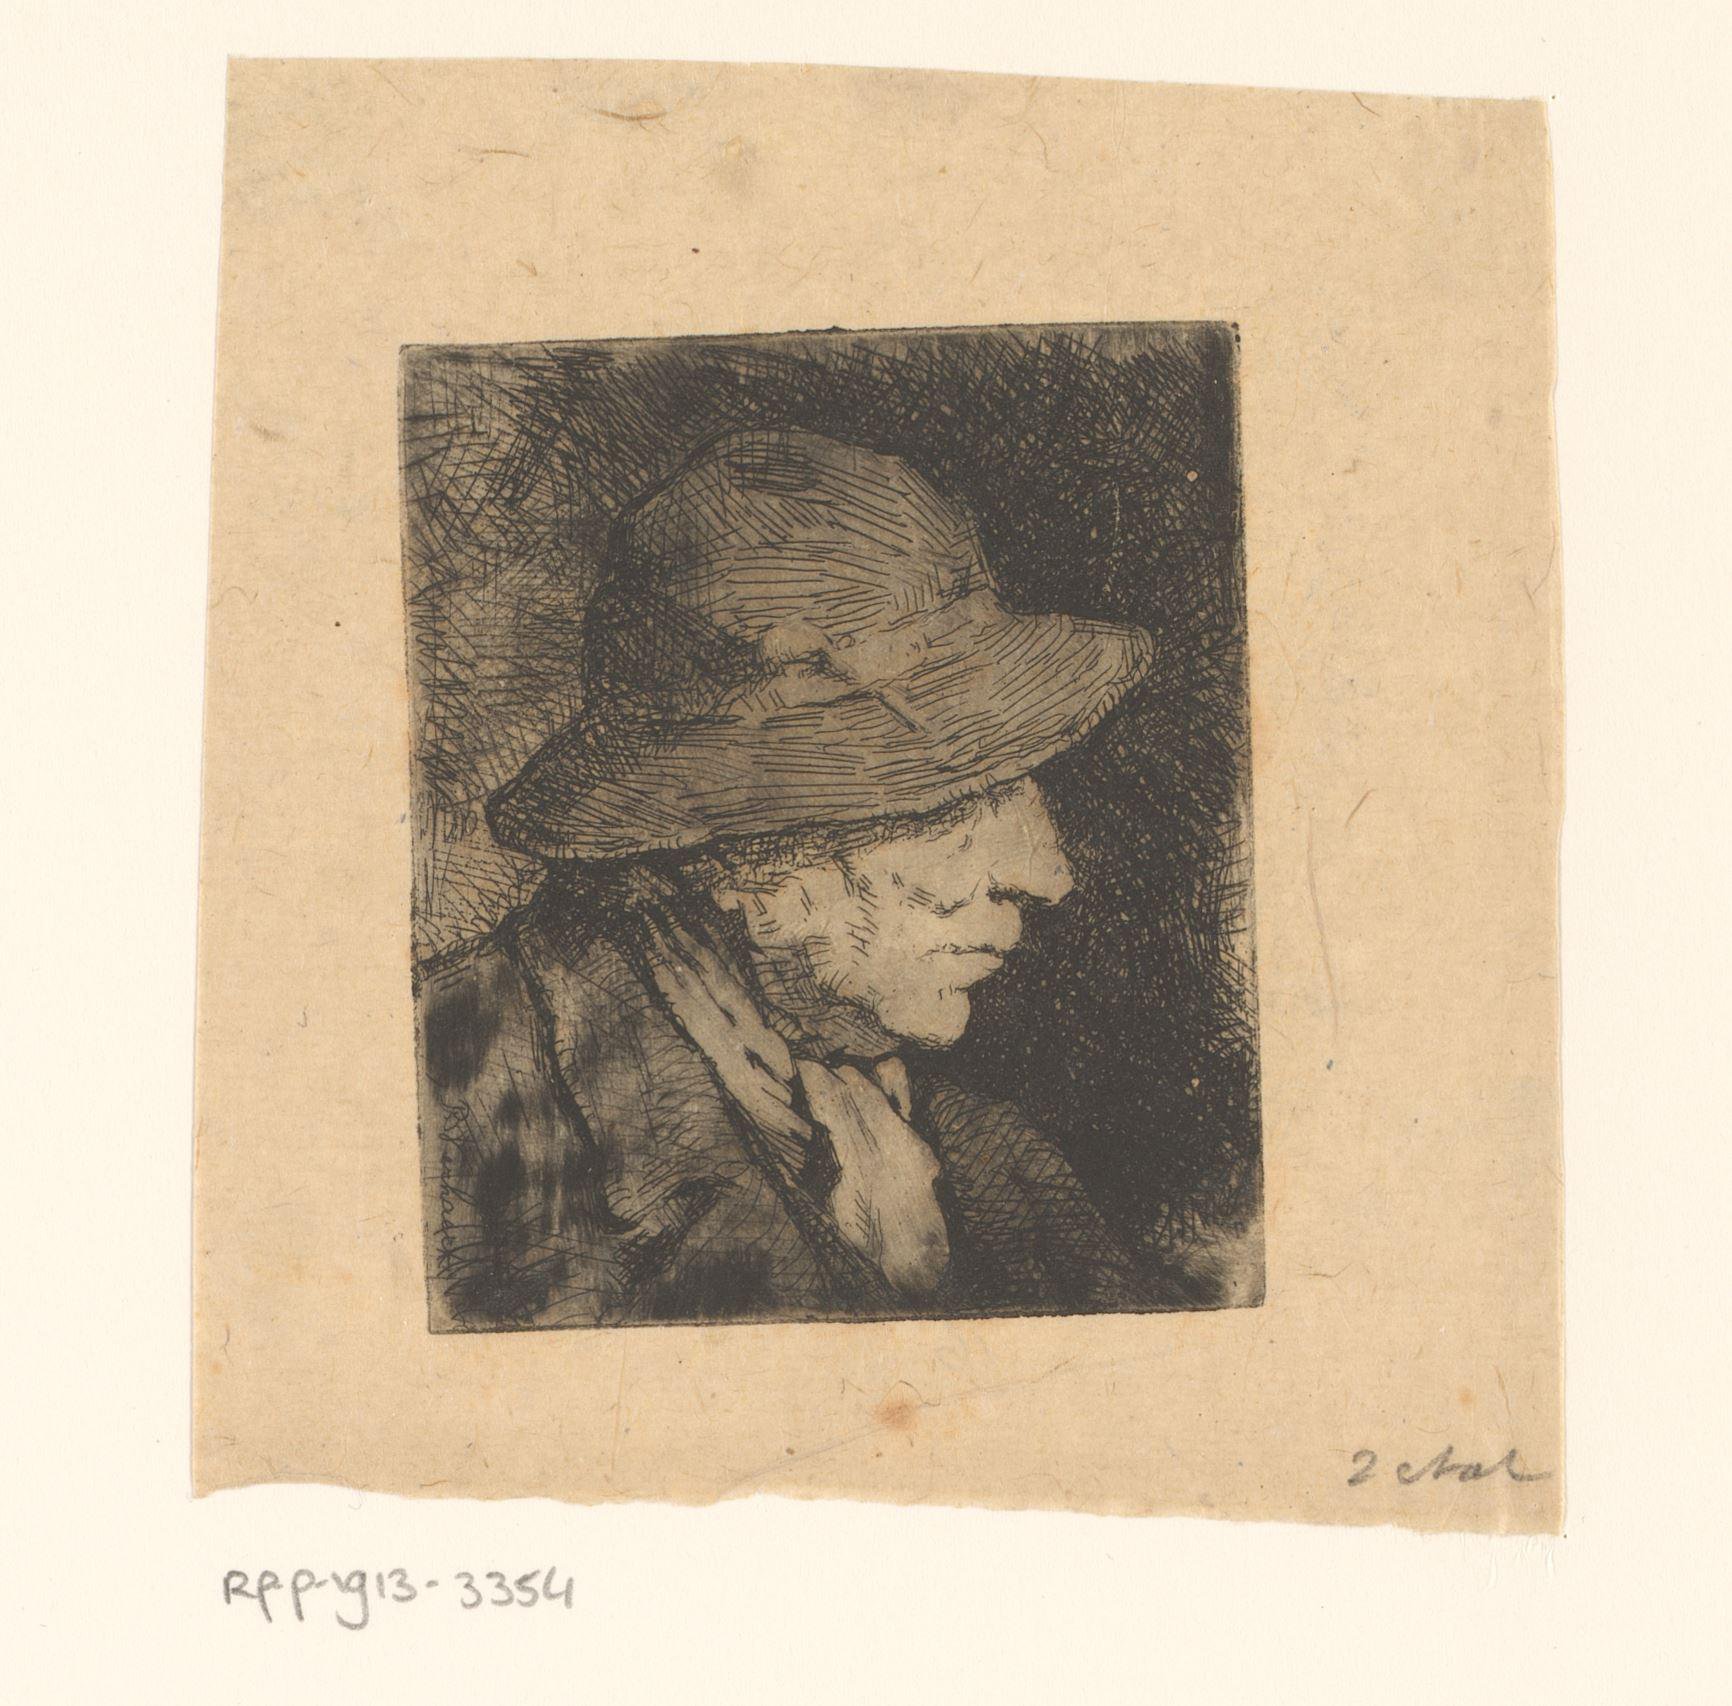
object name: print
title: Hoofd van een man met hoed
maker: piet verhaert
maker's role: print maker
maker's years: 1852-1908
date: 1879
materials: paper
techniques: etching, intaglio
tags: head-gear, adult man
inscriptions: inscription: ‘2 etat’, collector's mark: Lugt 2228